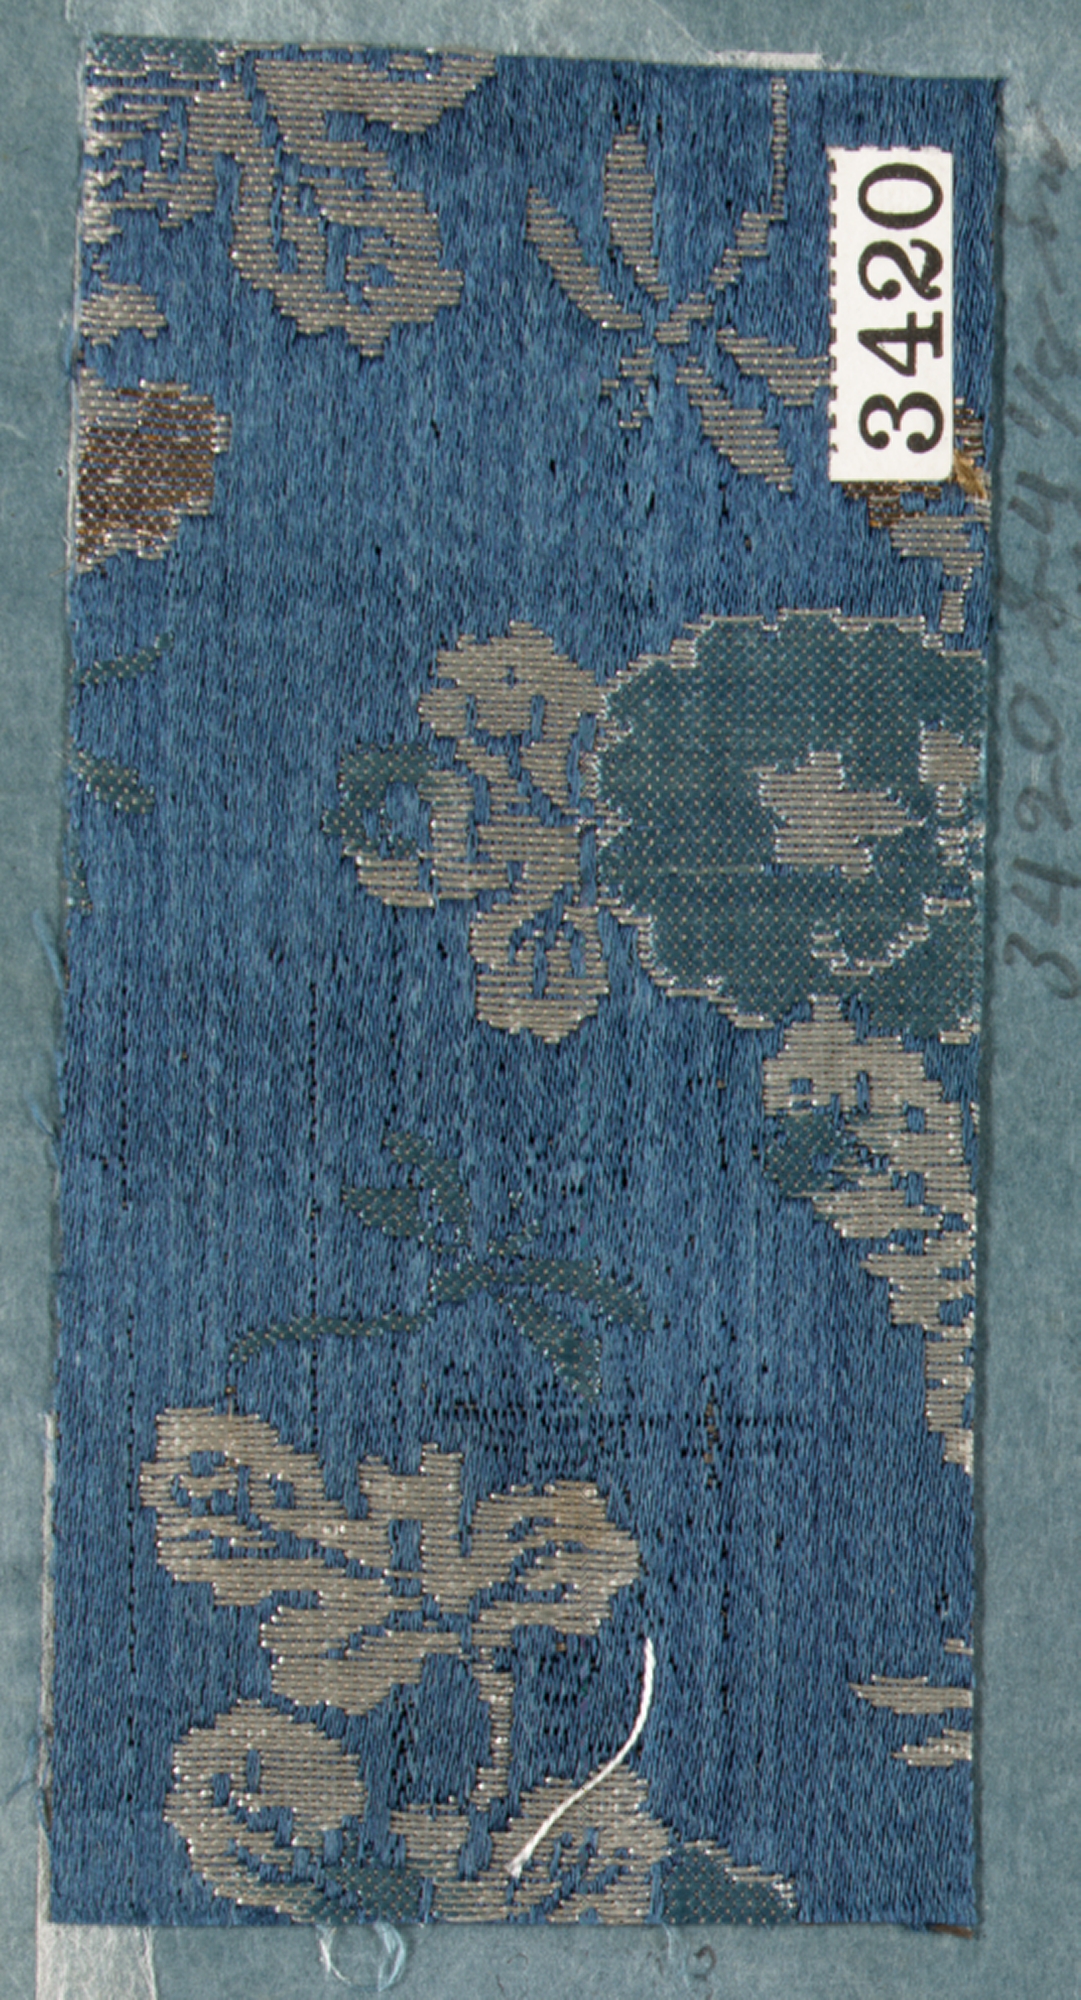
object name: textile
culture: japanese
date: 1801-1900